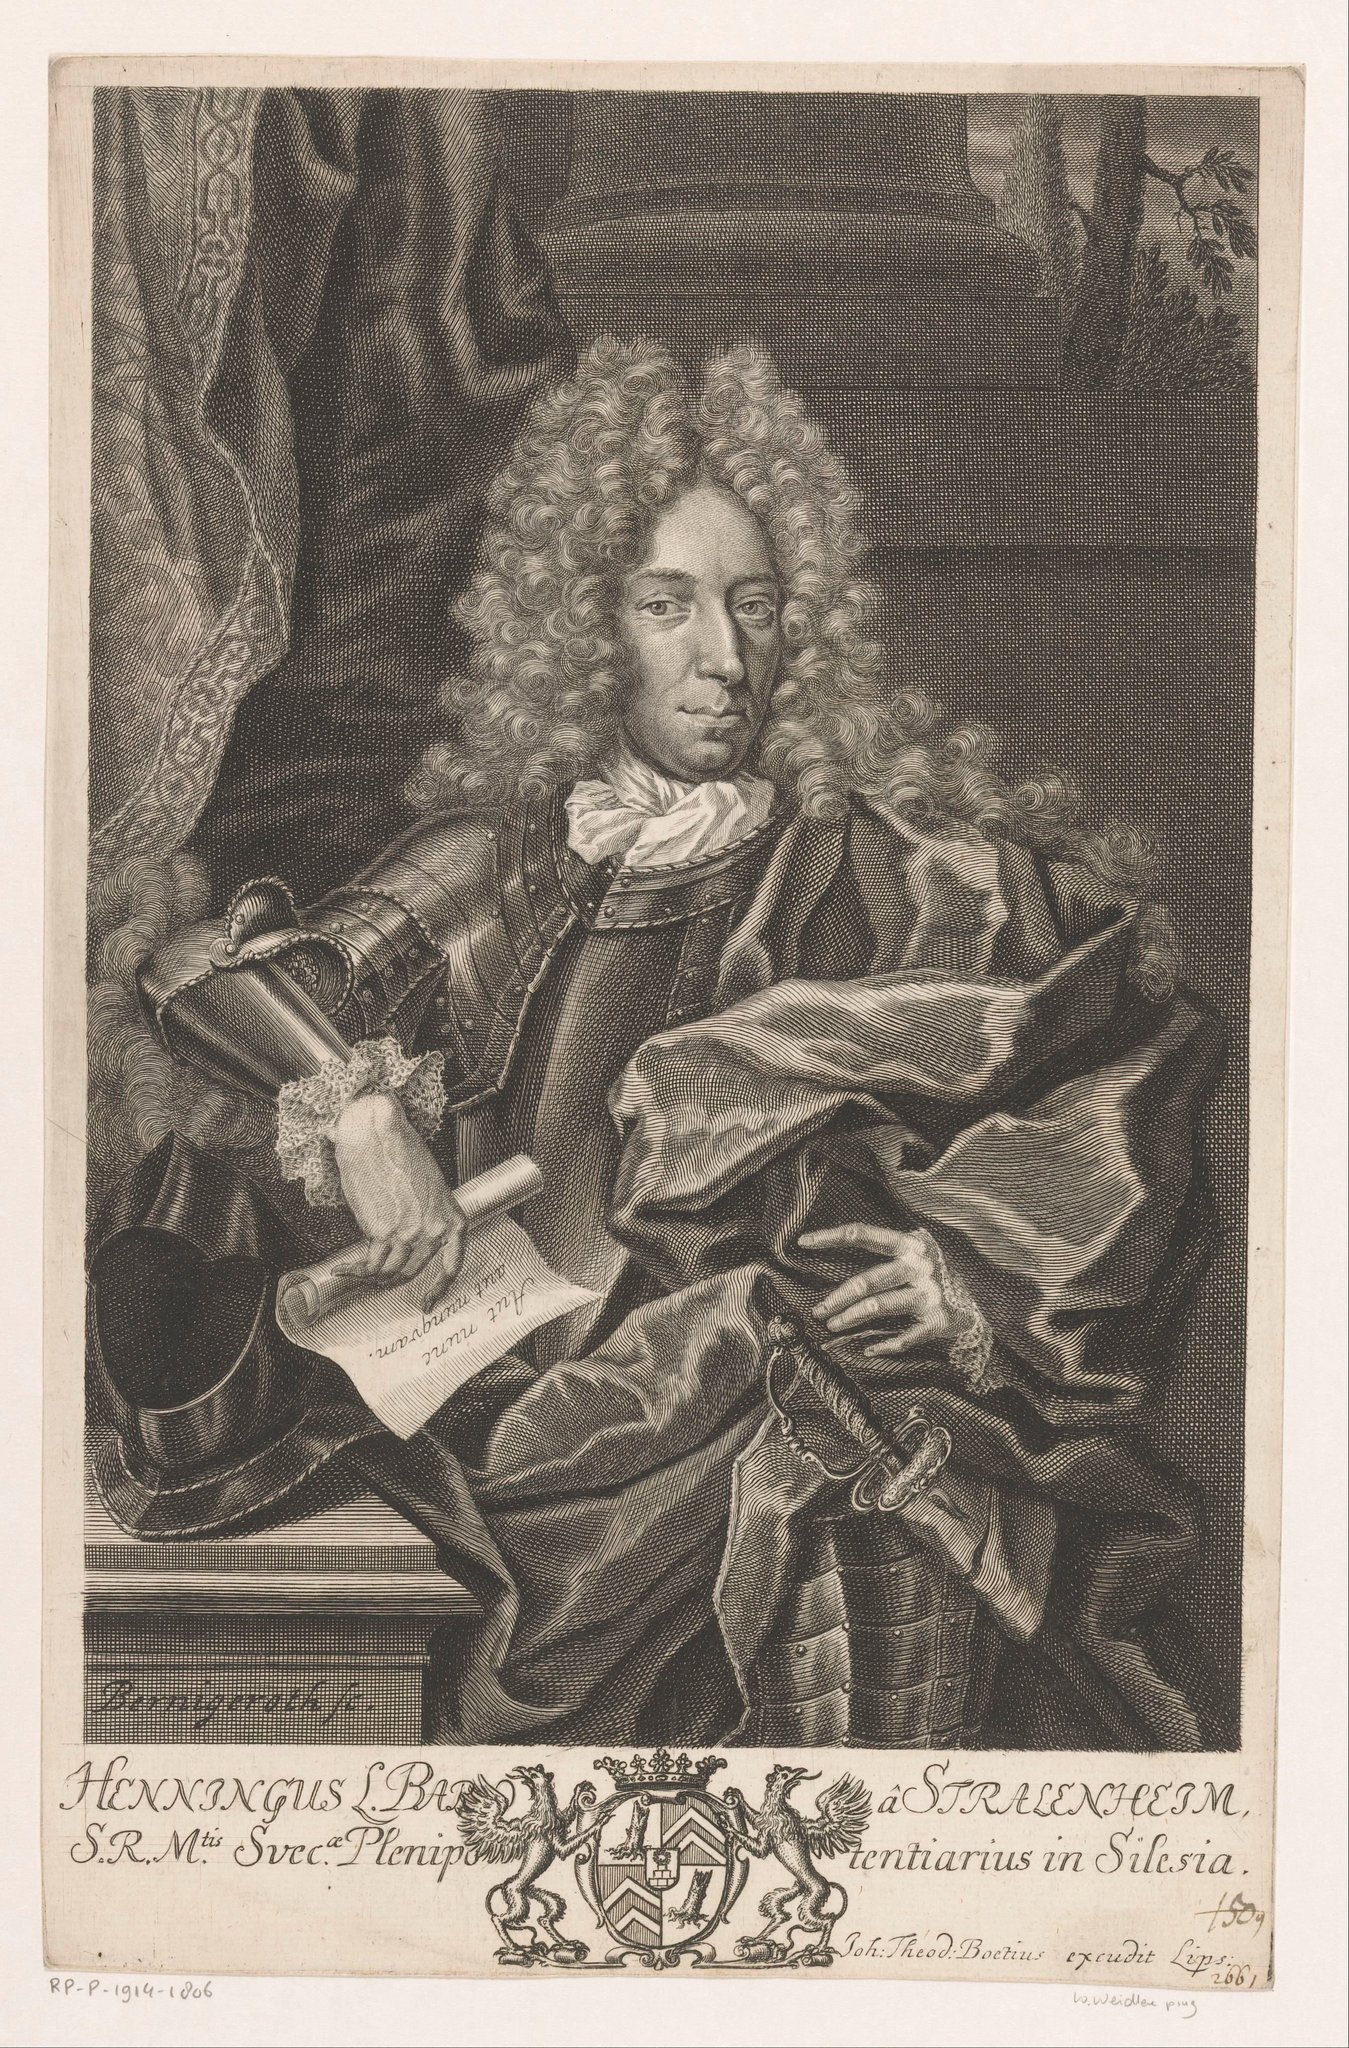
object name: print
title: Portret van Henning von Stralenheim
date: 1698-1722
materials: paper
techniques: engraving, etching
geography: leipzig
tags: armour, historical persons, letter, envelope, armorial bearing, heraldry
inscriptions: collector's mark: Lugt 2228